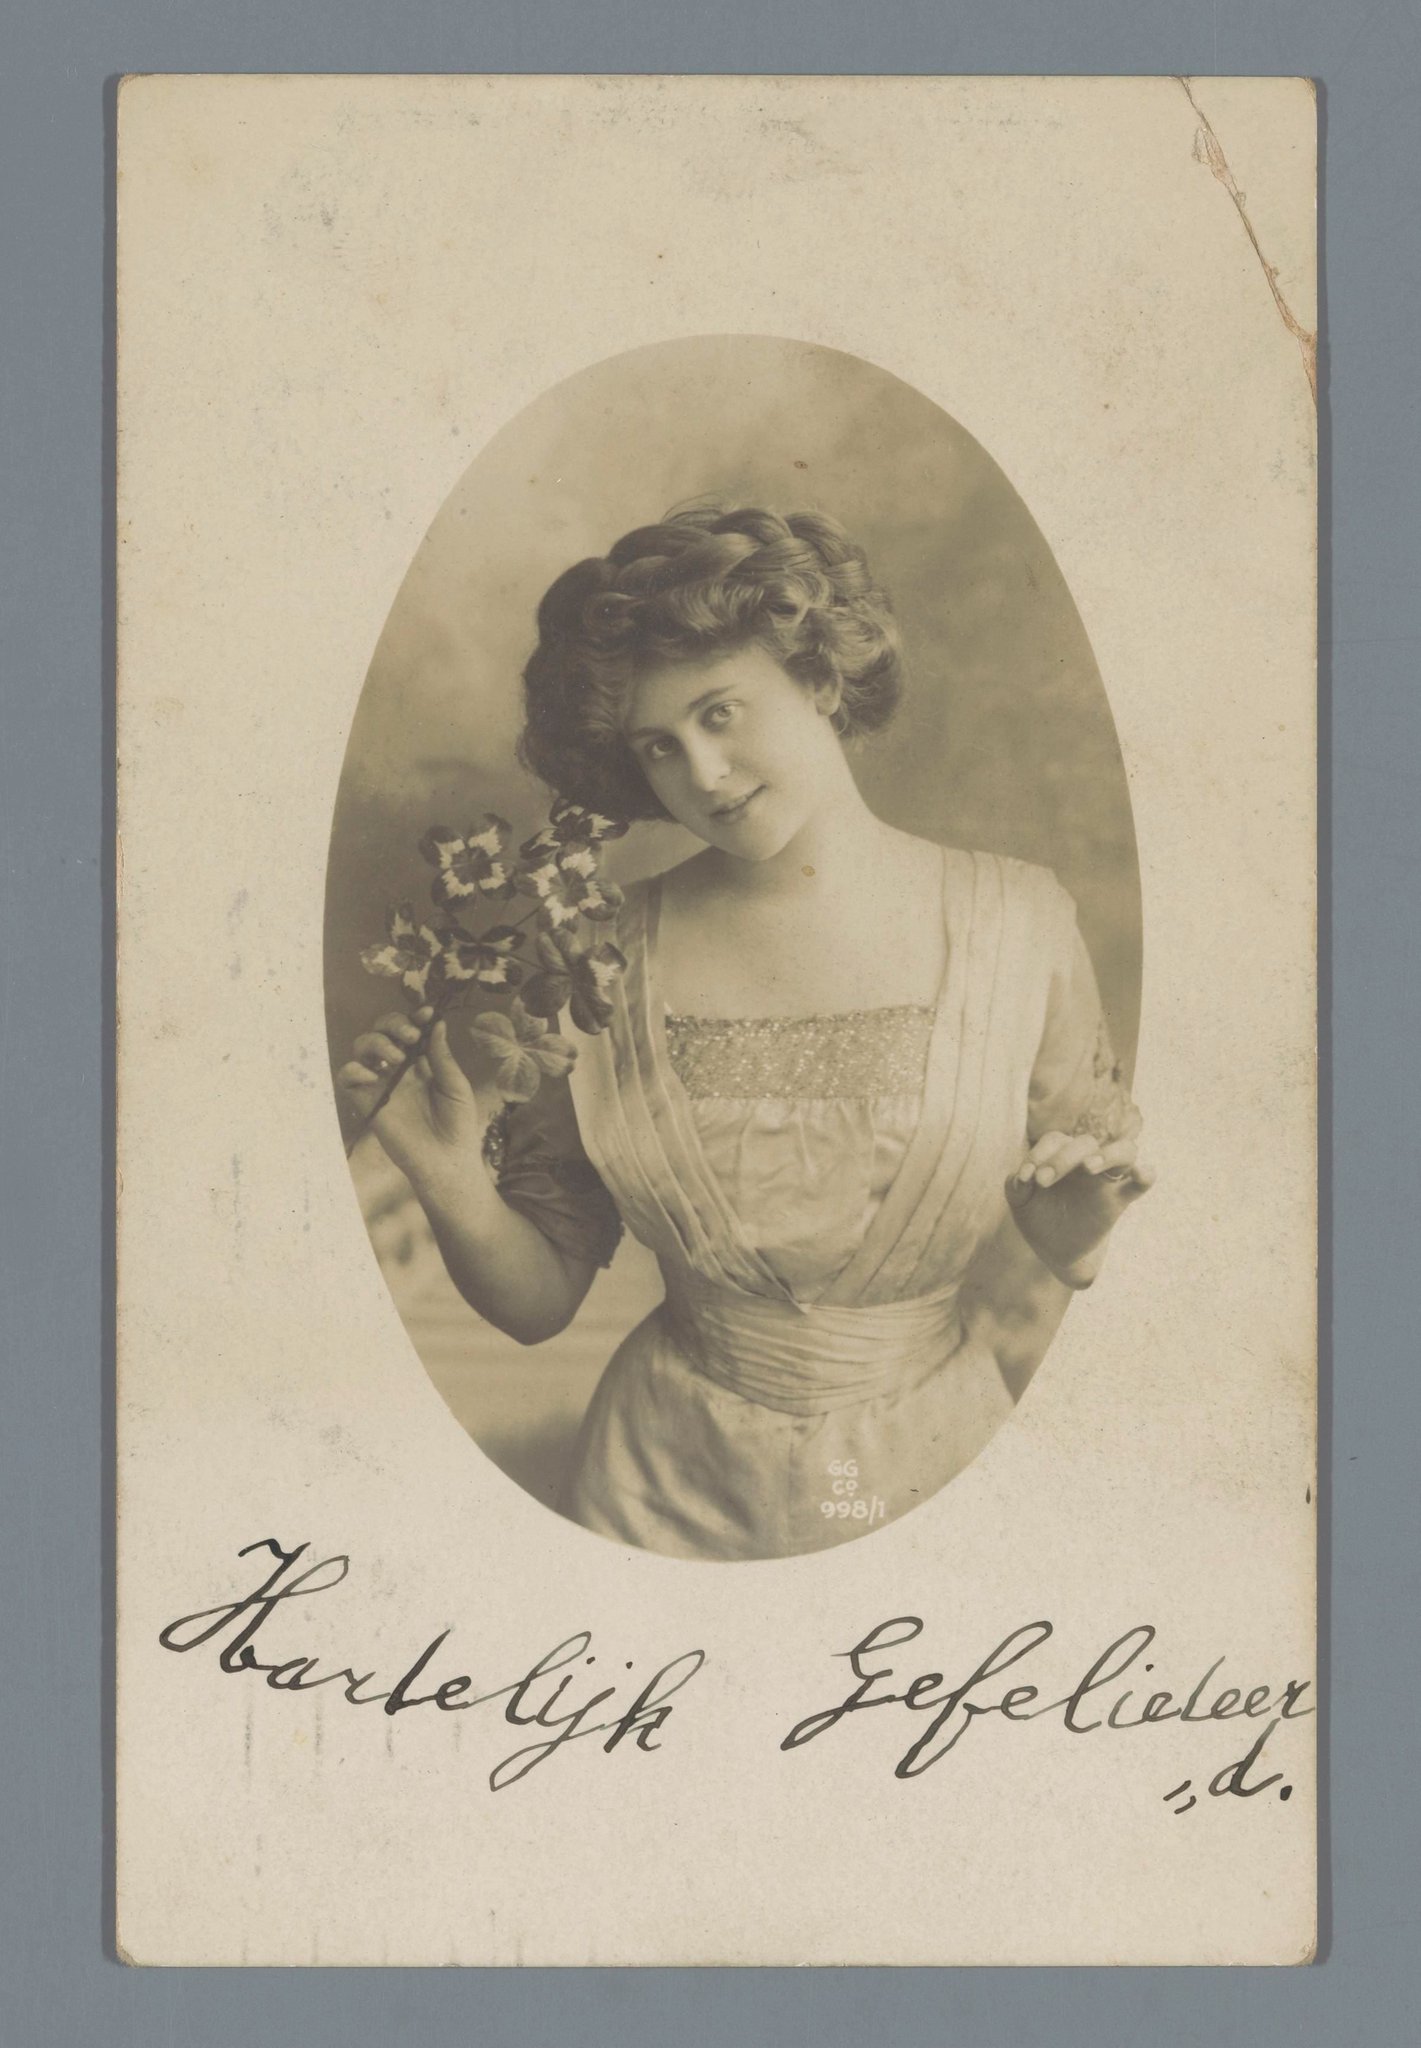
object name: photograph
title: Portret van een onbekende vrouw met een tak in de hand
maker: Anonymous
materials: photographic support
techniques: gelatin silver print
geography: berlin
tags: adult woman, plants; vegetation (+ branch, stick)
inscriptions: date: ‘17 XII 12’, inscription: ‘Hartelijk Gefelieteerd.’, inscription: ‘Afzenster (...) Amsterdam’